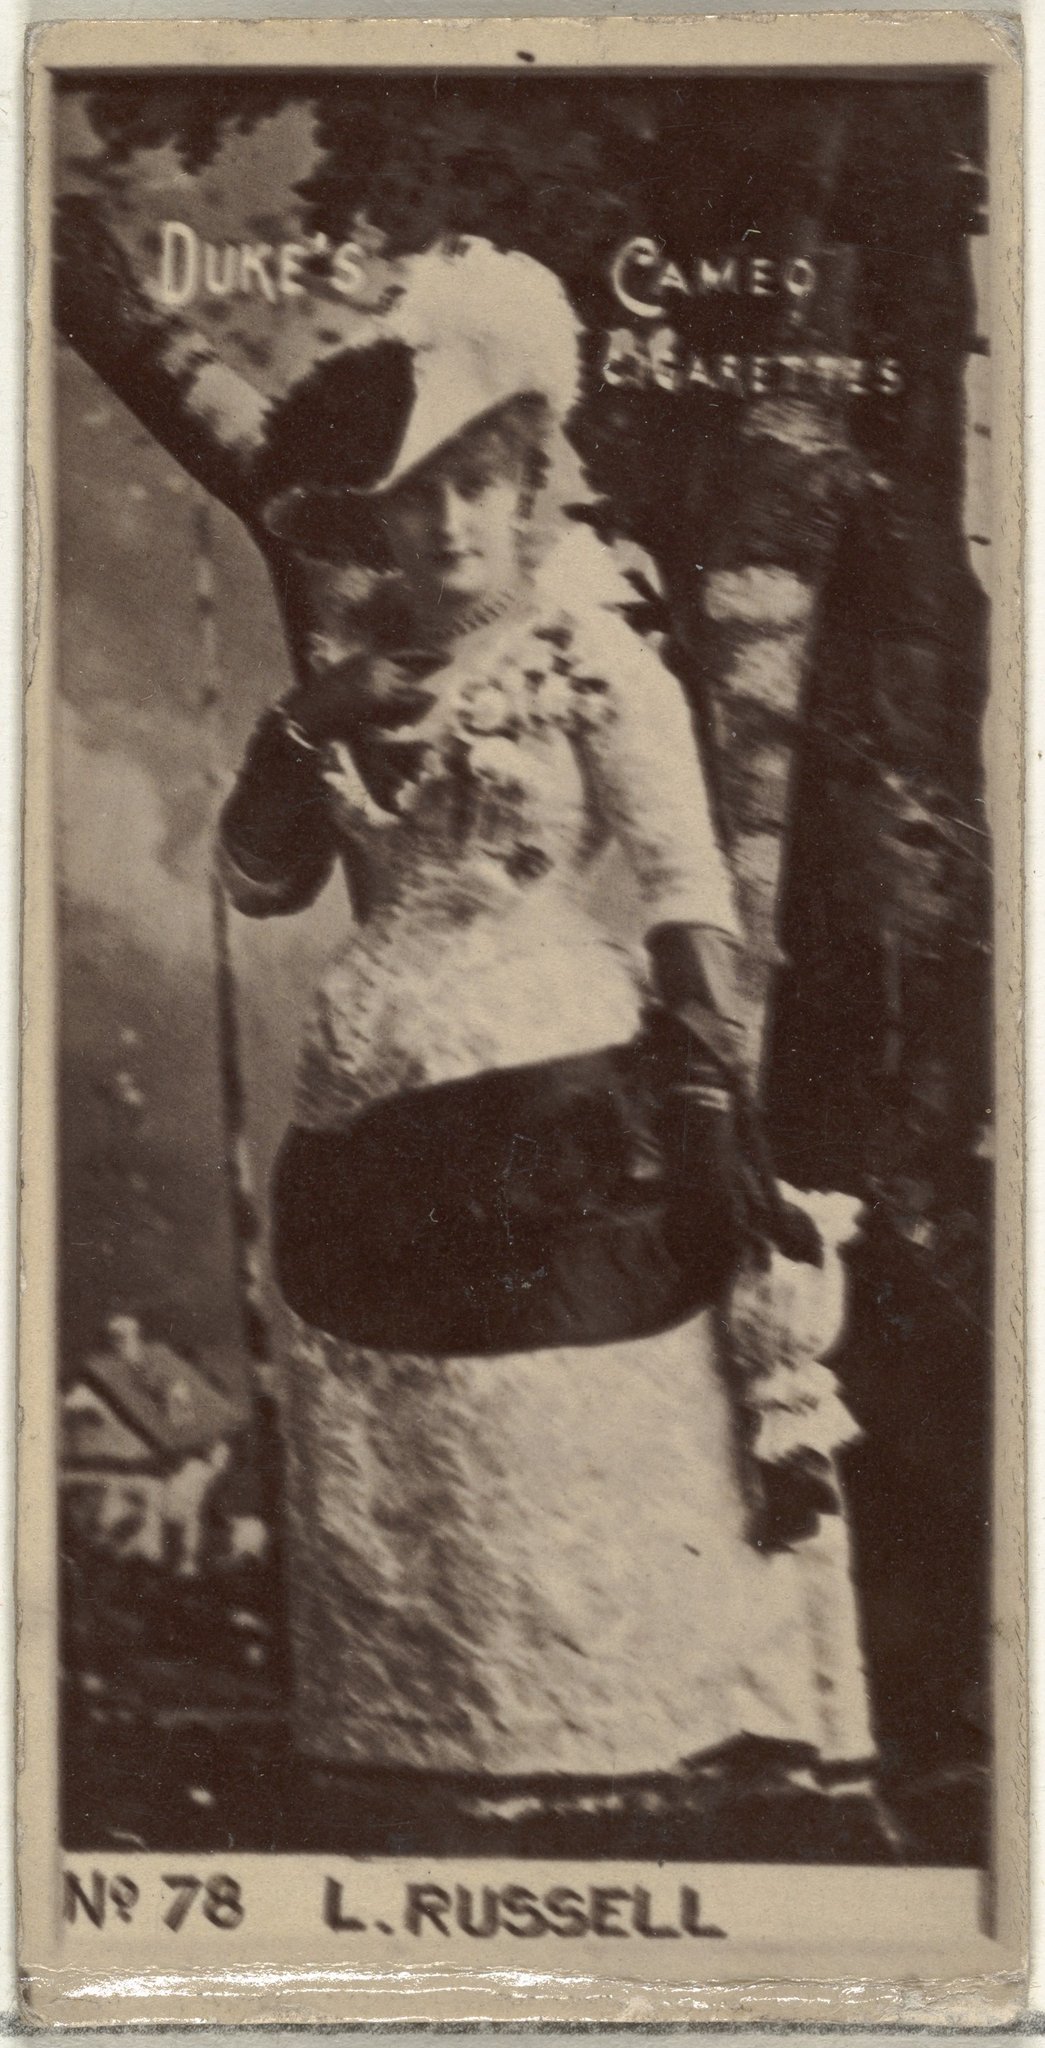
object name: photograph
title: Card Number 78, Lillian Russell, from the Actors and Actresses series (N145-4) issued by Duke Sons & Co. to promote Cameo Cigarettes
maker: w. duke, sons & co.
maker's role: publisher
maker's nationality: american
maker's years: 1870-1920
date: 1880-1889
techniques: albumen silver print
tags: portraits,women,actresses